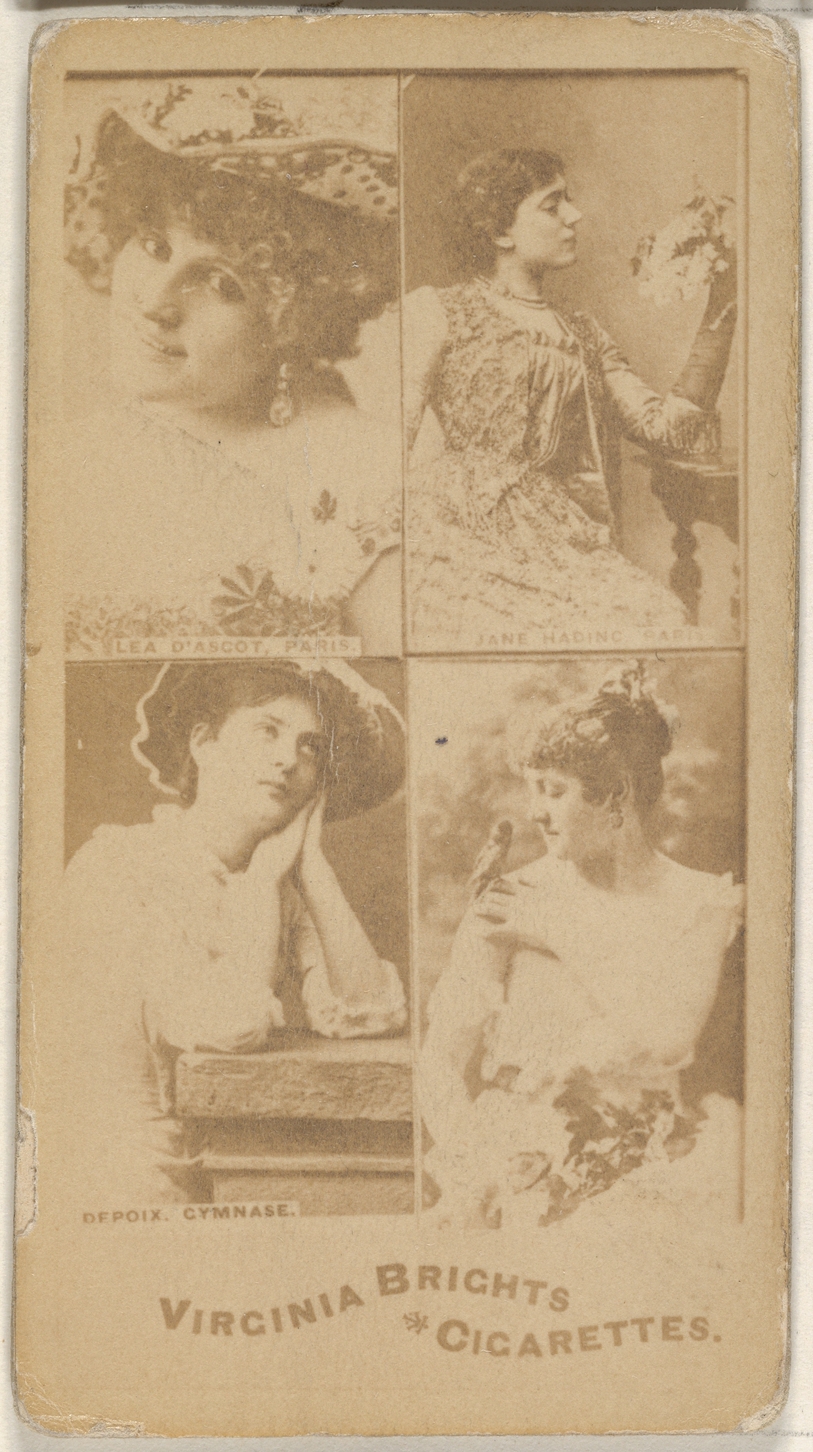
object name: photograph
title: Lea D' Ascot, Paris/ Jane Hading, Paris/ Depoix, Gymnase, from the Actors and Actresses series (N45, Type 4) for Virginia Brights Cigarettes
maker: allen & ginter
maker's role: publisher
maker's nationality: american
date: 1888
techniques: albumen silver print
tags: portraits,women,actresses